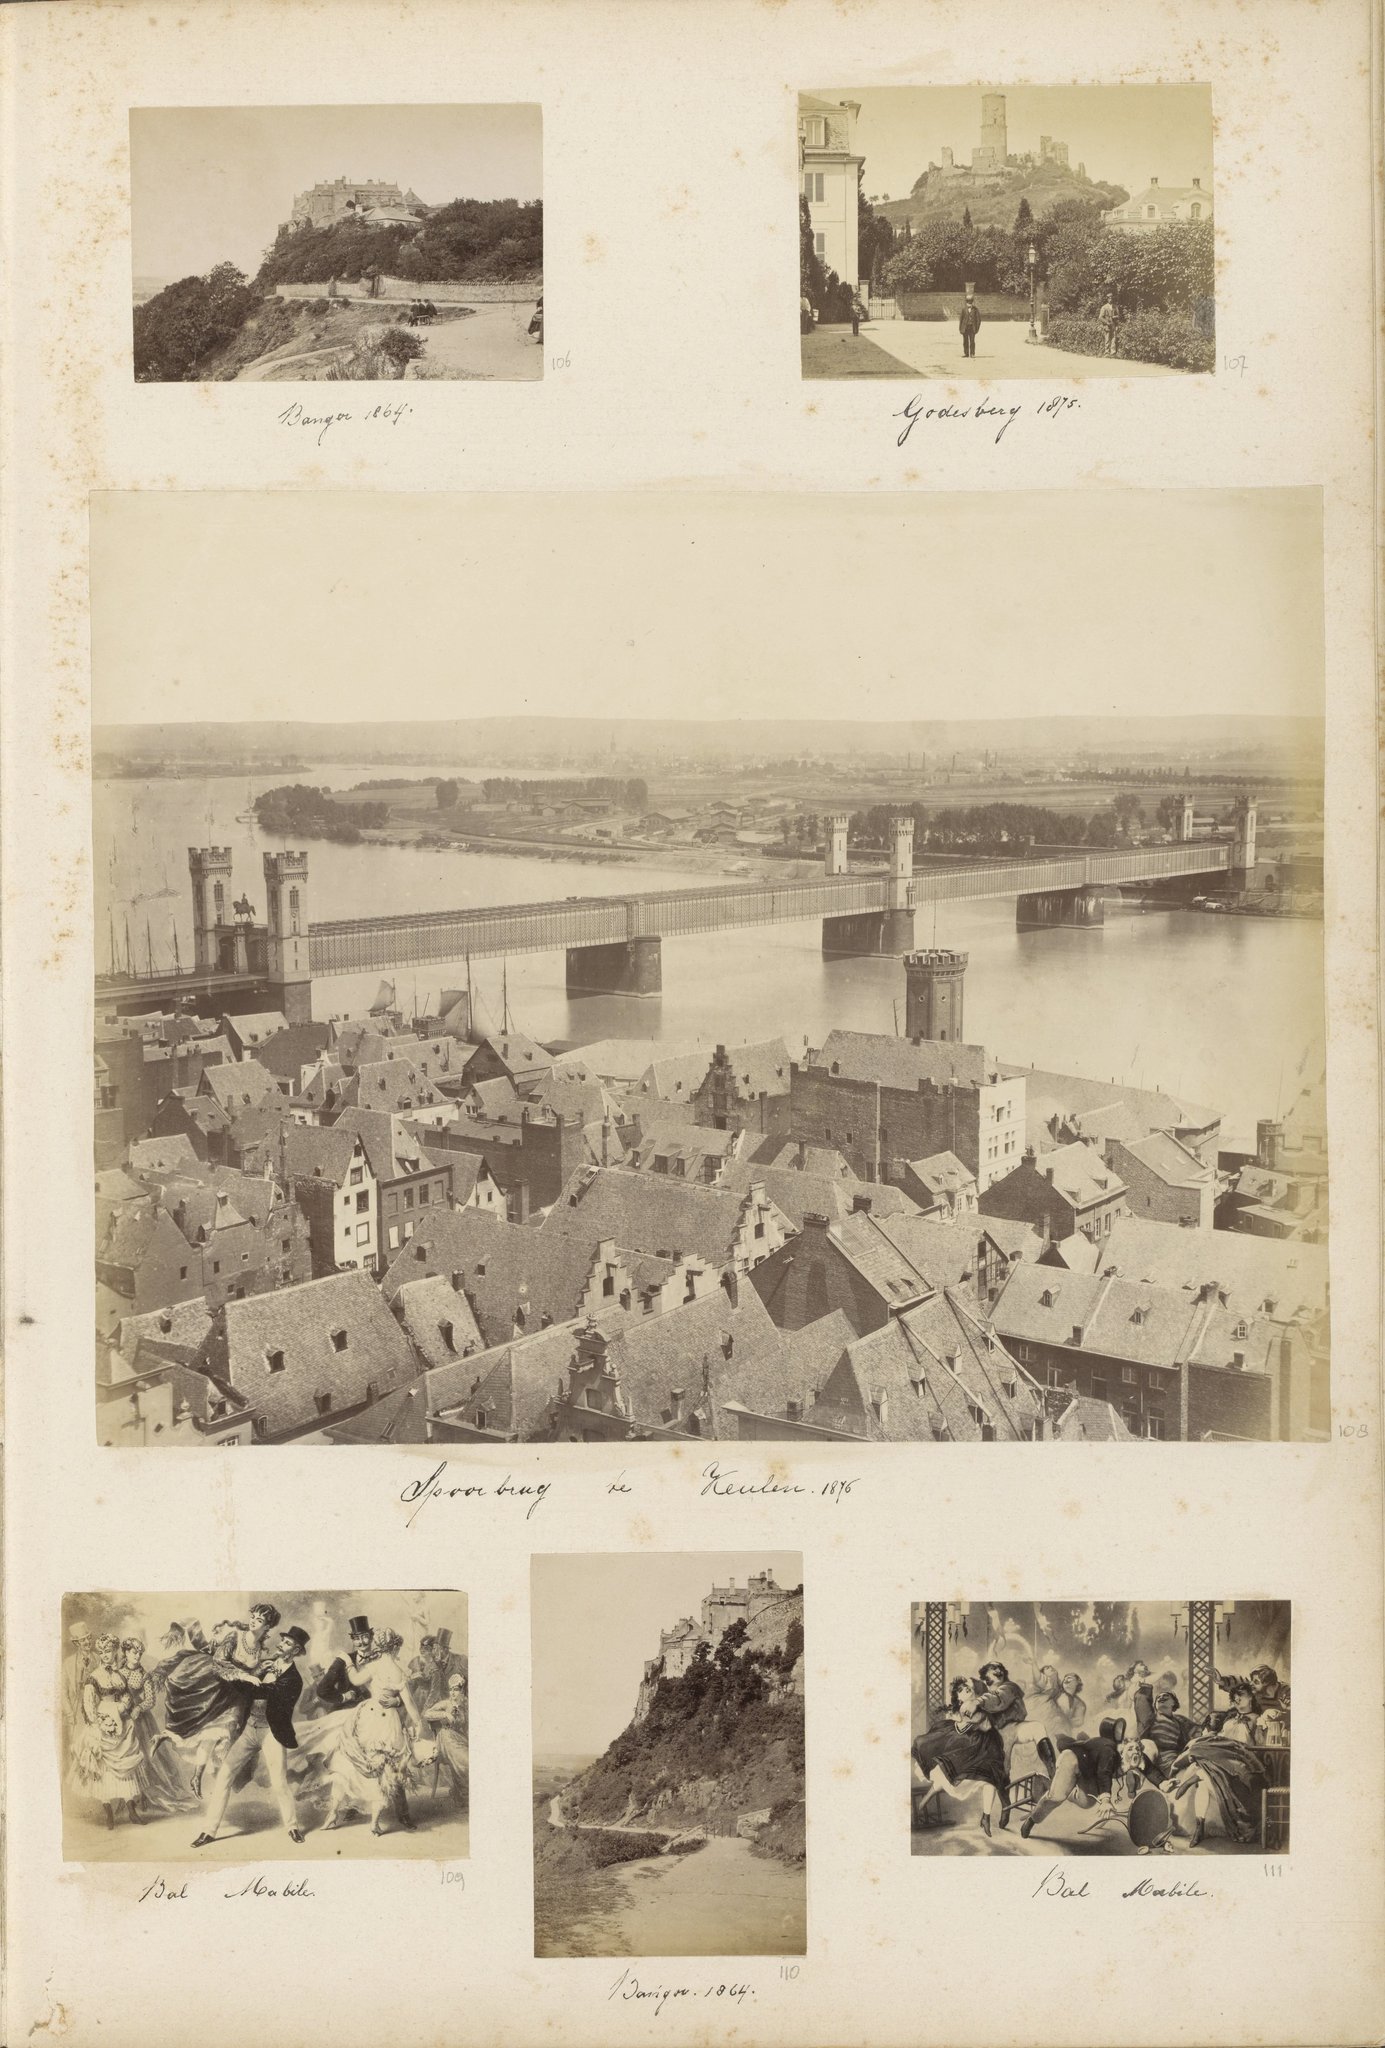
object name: album leaf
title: Gezicht op een stad op een heuvel, mogelijk in Duitsland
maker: Anonymous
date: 1864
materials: paper, photographic support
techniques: albumen print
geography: germany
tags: prospect of village, silhouette of village, germany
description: Onderdeel van Fotoalbum van Robert Daniel Crommelin (1841-1907).